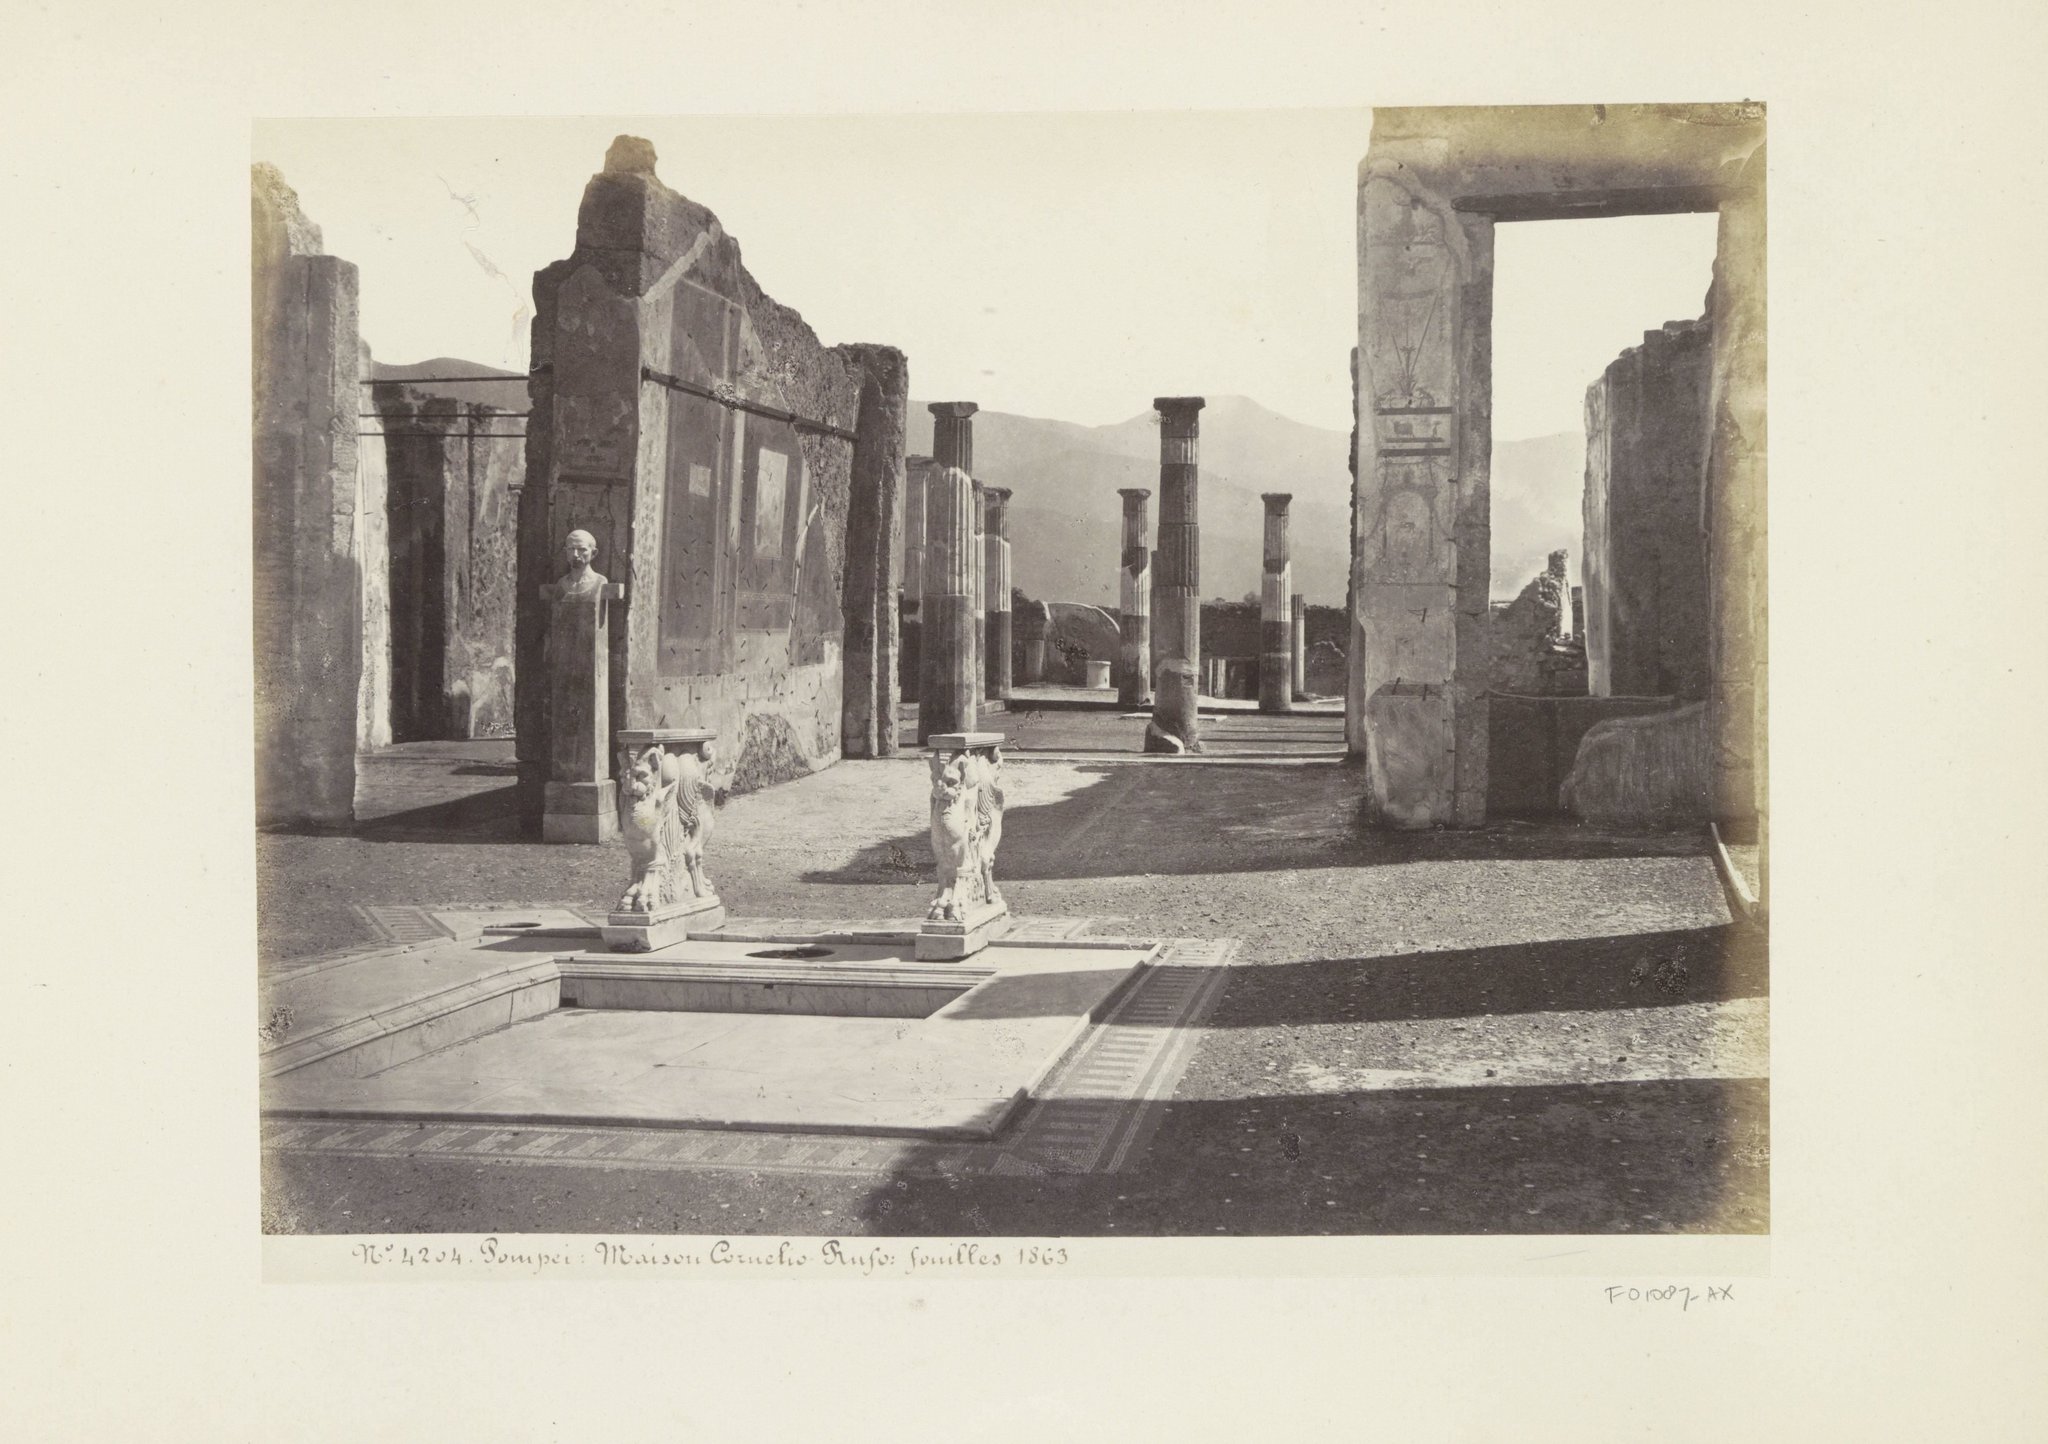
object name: photograph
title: Pompei: Maison Cornelio Rufo: fouilles 1863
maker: Anonymous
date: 1865-1875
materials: paper, photographic support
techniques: albumen print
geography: pompeii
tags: piece of sculpture, reproduction of a piece of sculpture (+ sculpture), column, pillar ~ architecture, excavation ~ archaeology, pompeii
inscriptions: negative number: ‘4204’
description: Onderdeel van Reisalbum met foto's van bezienswaardigheden in Napels en omgeving.